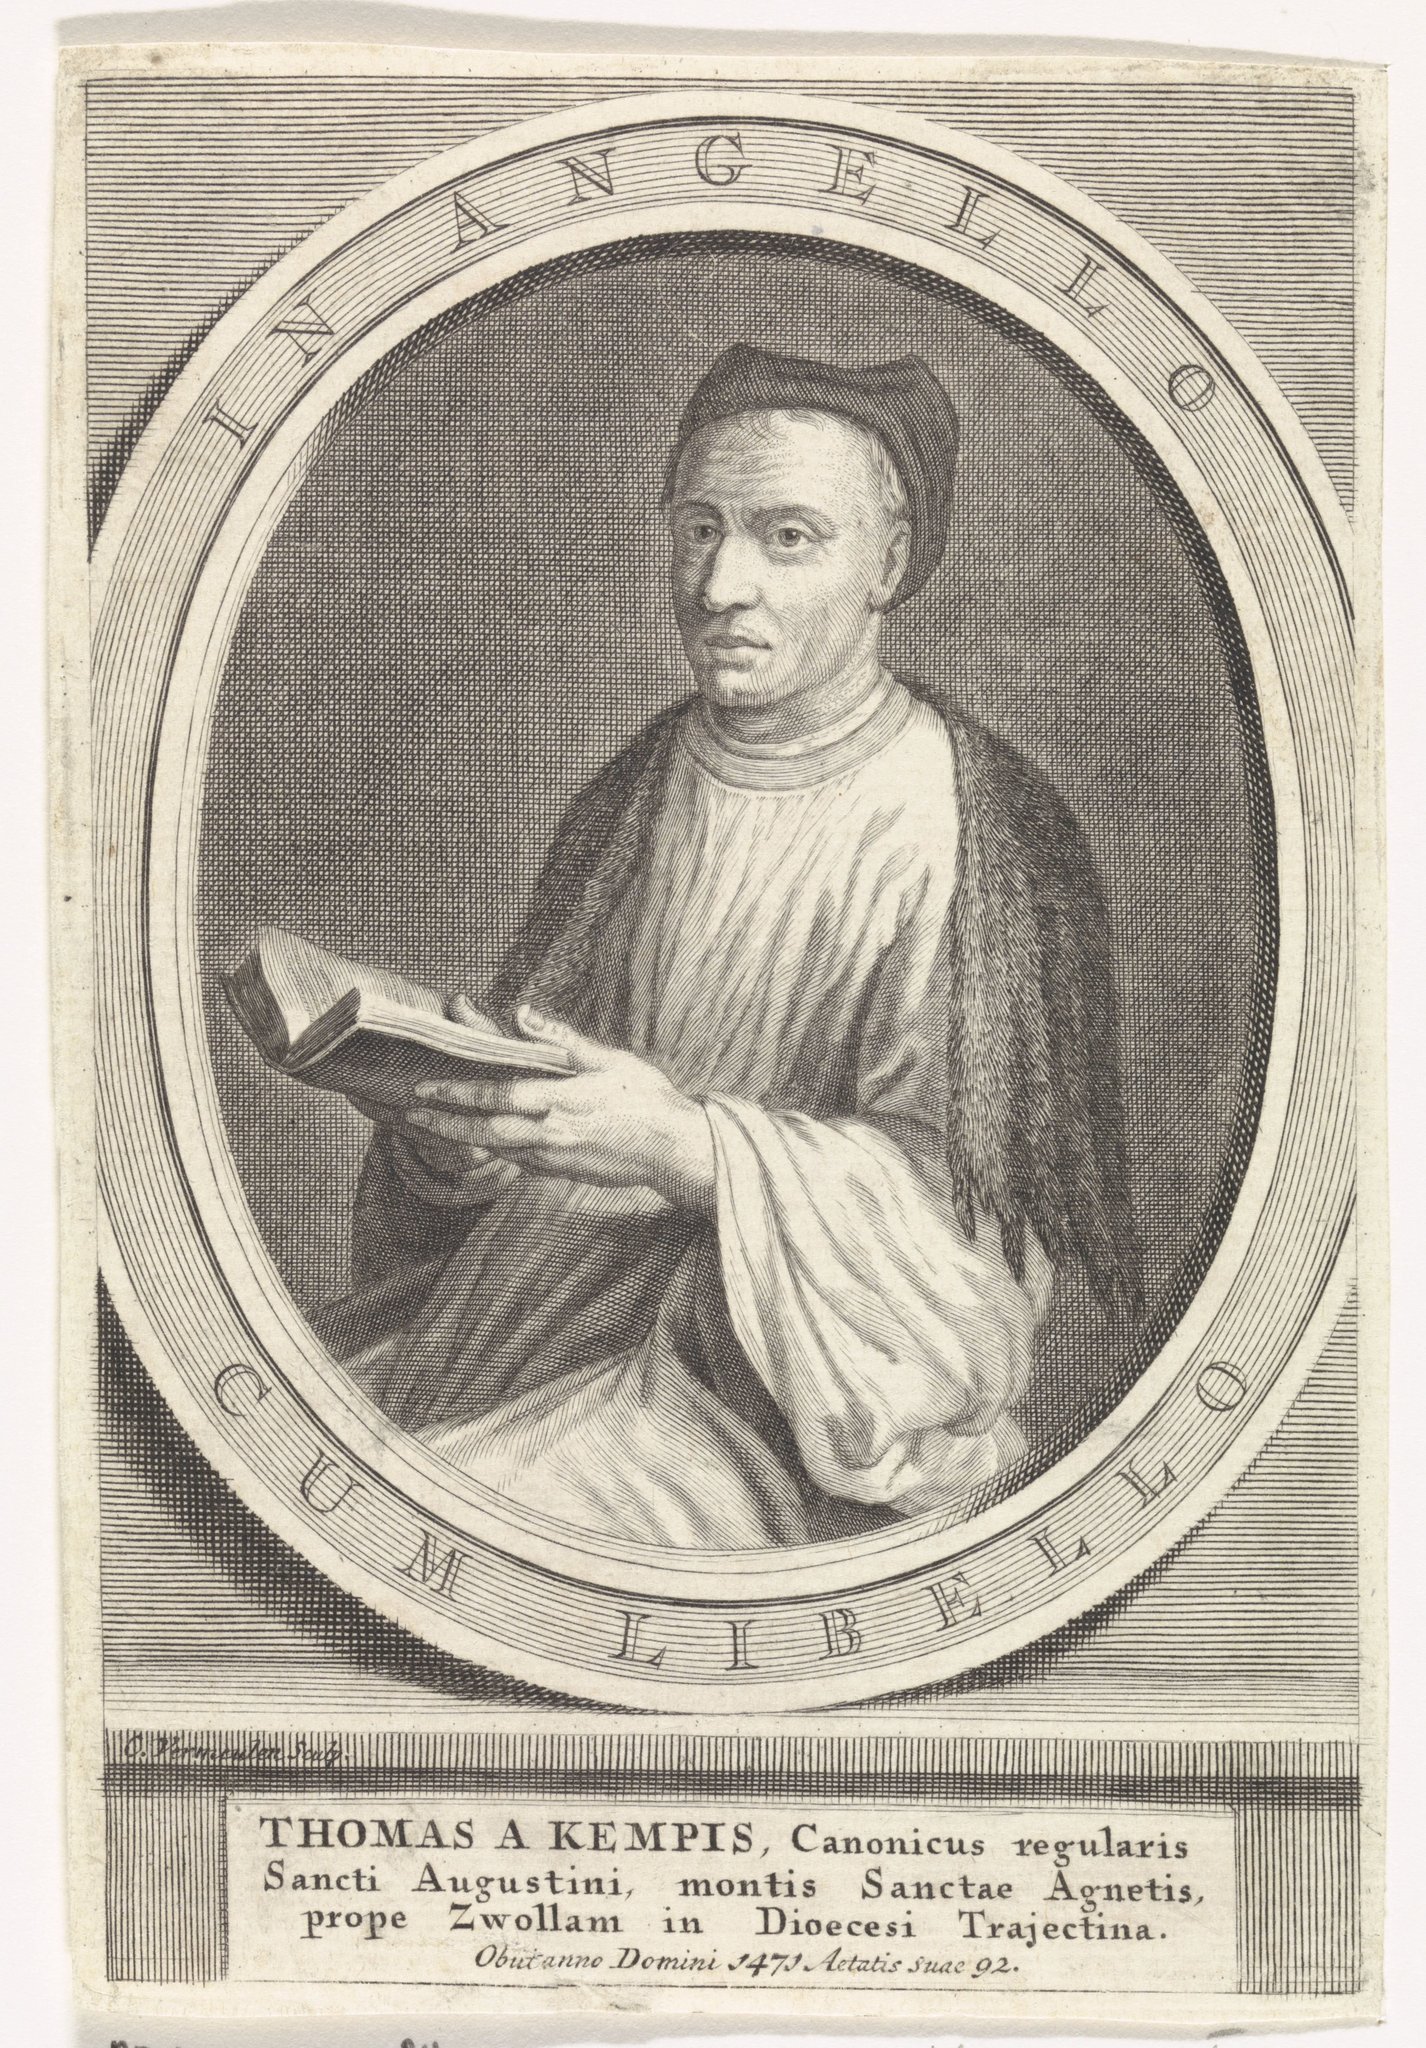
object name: print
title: Portret van Thomas à Kempis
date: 1654-1709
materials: paper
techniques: engraving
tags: priest, thomas à kempis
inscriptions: collector's mark: Lugt 2228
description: Portret van Thomas à Kempis, schrijver en monnik in het Agnietenbergklooster bij Zwolle.